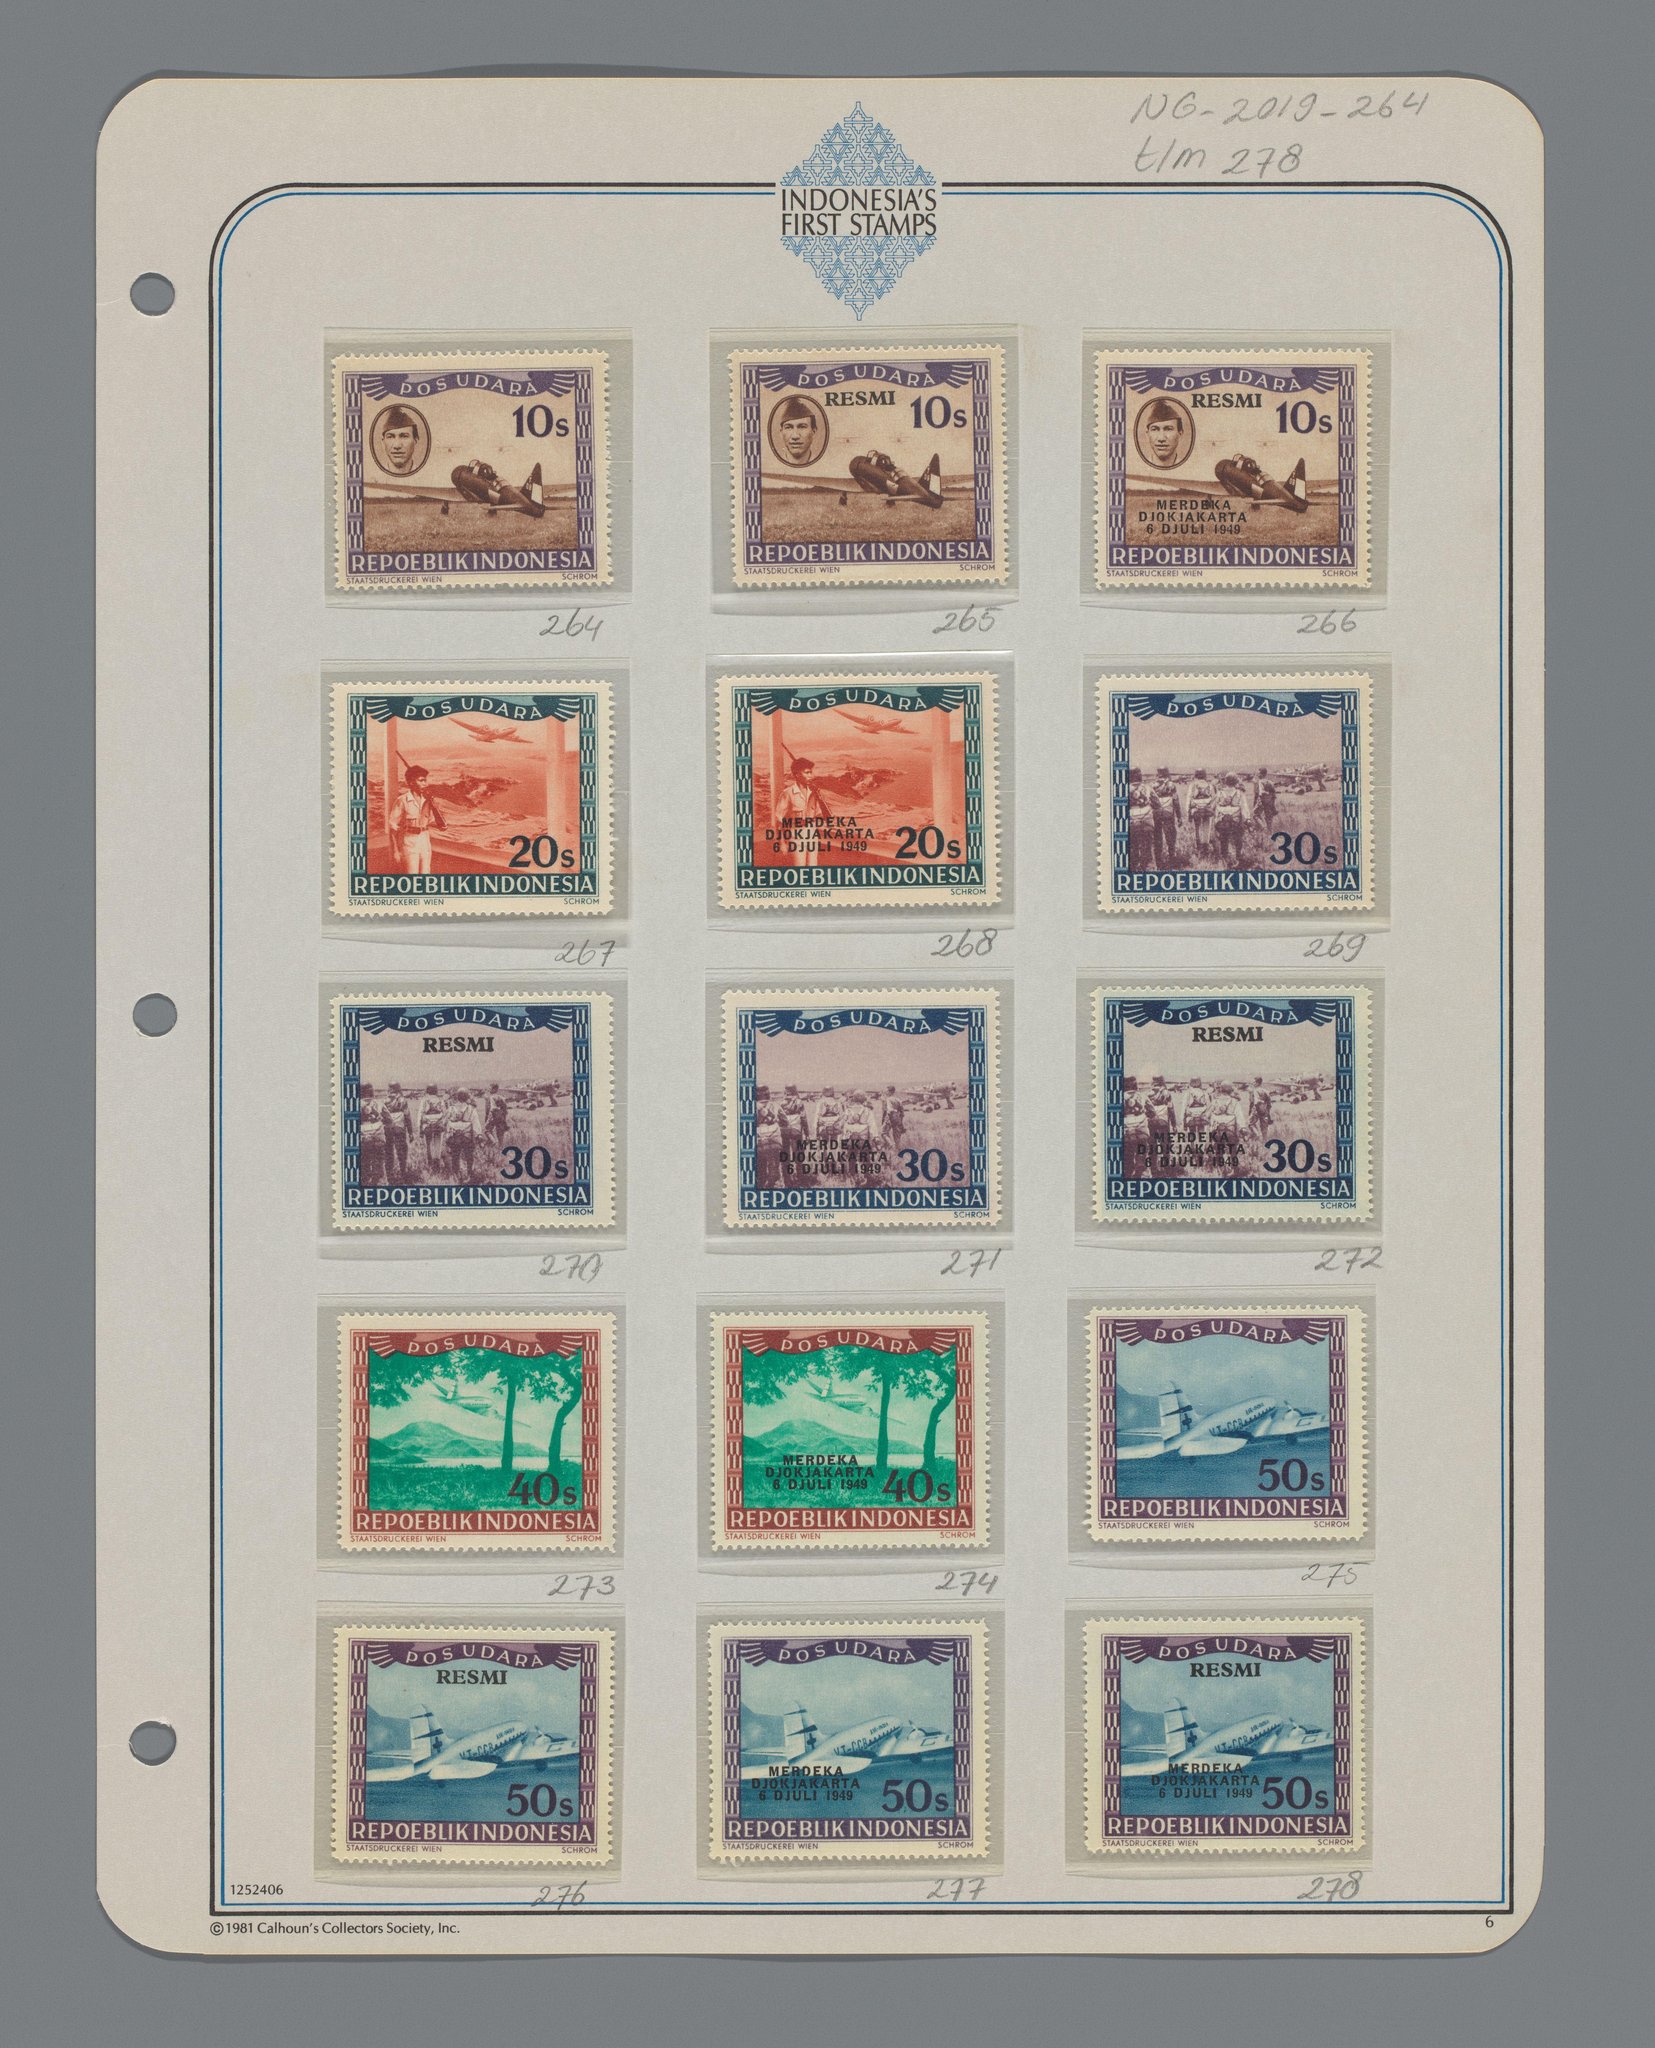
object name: postage stamp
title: Postzegel Republik Indonesia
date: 1949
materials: paper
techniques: photoaquatint, engraving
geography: vienna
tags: indonesia